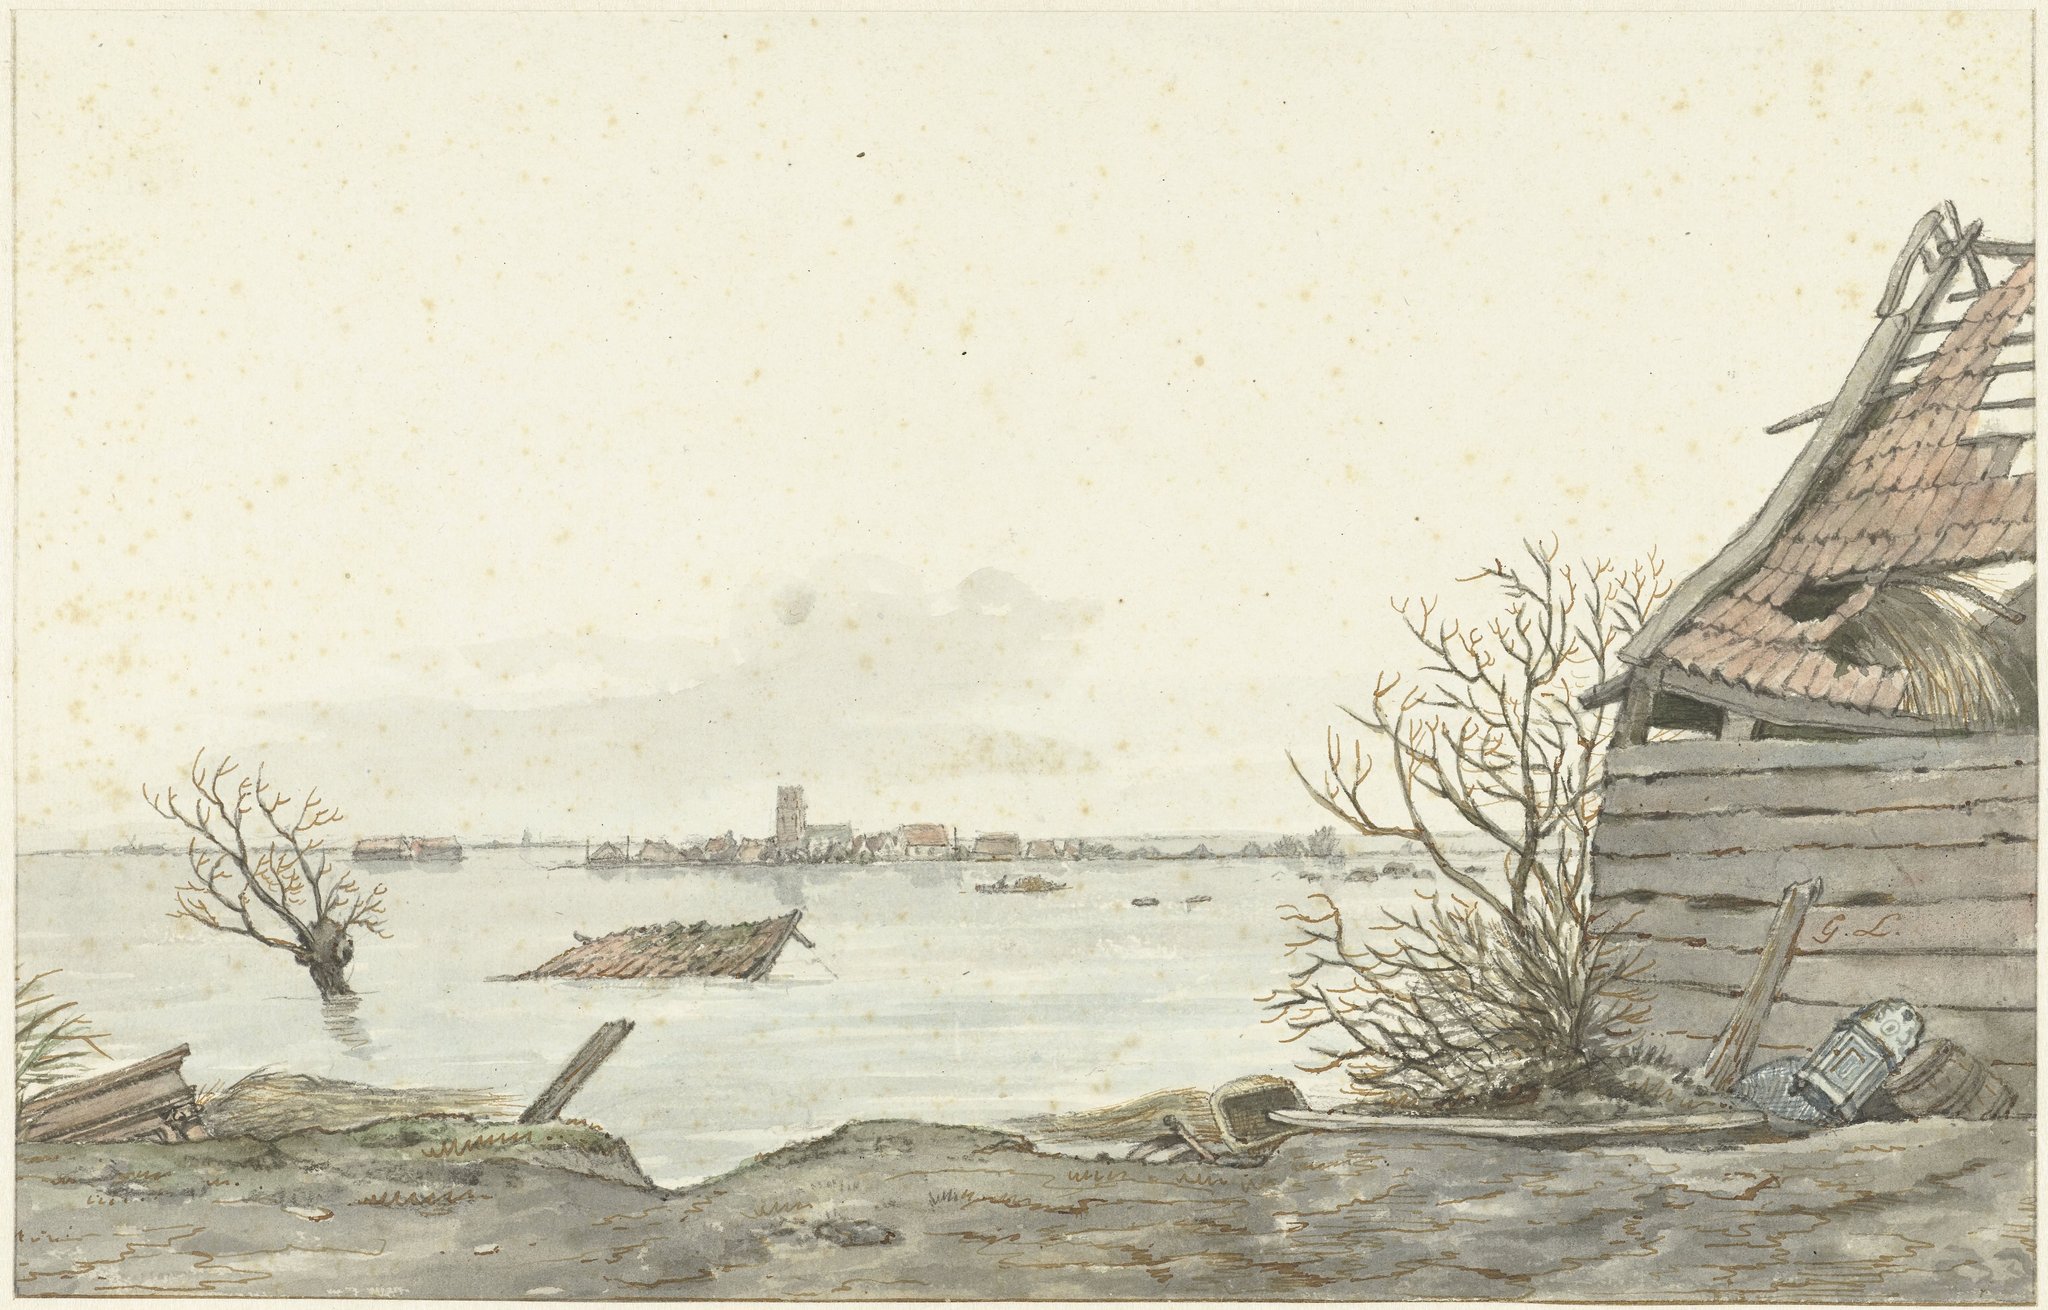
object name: drawing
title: Gezicht op het overstroomde Ransdorp, februari 1825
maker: gerrit lamberts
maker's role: bookseller, draughtsman, print maker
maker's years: 1776-1850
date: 1802-1825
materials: chalk, ink, paper, watercolor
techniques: brush, pen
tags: swamps and polders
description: Niet in Frederik Muller; door het RPK toegevoegd nummer.